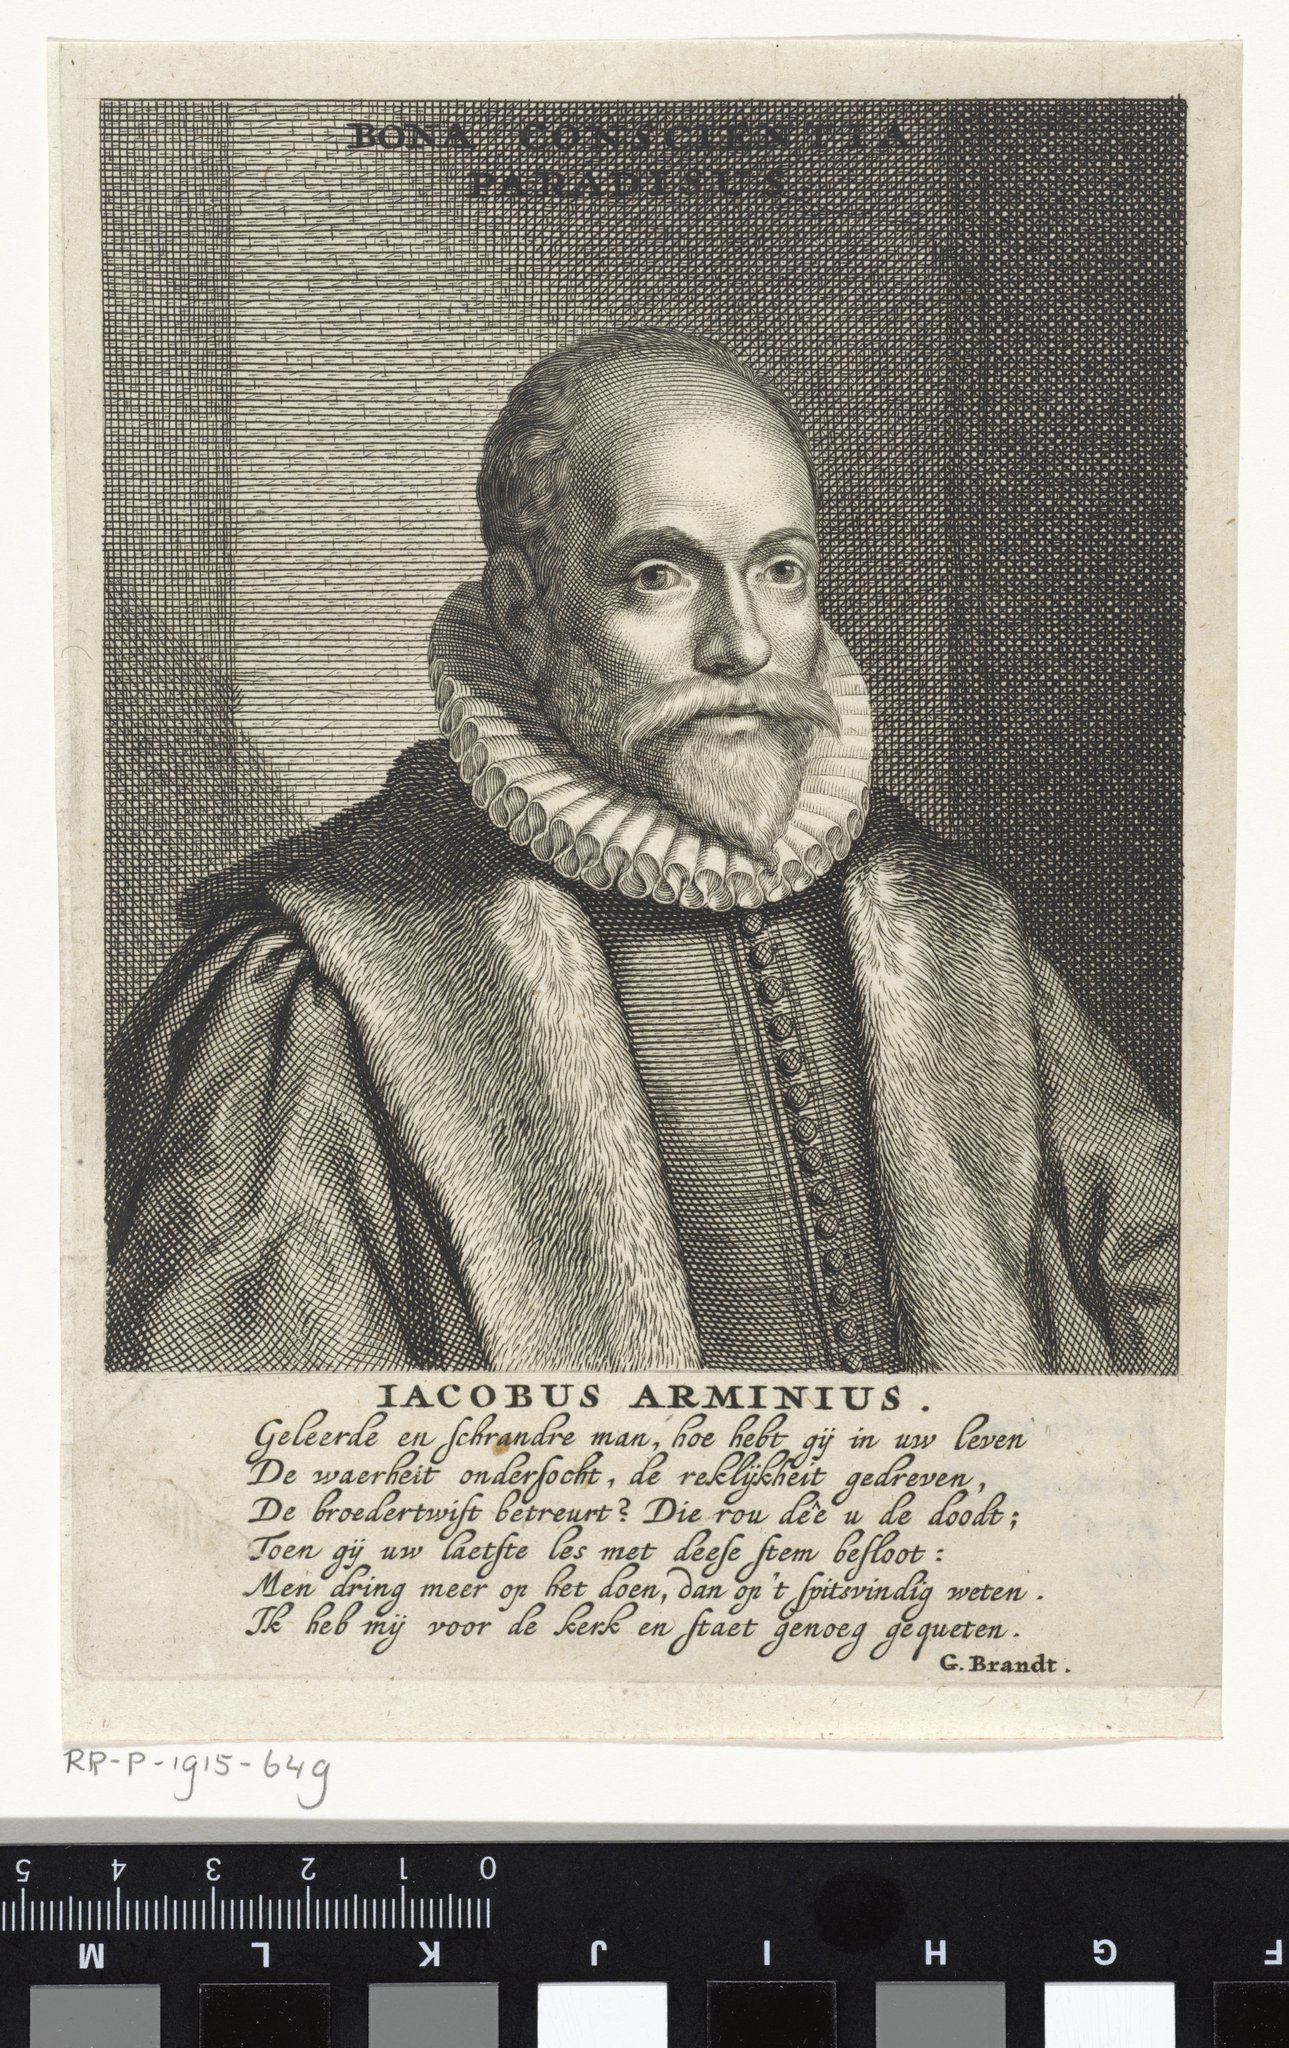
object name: print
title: Portret van Jacobus Arminius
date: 1696-1704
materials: paper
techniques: engraving, etching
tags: leiden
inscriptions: collector's mark: Lugt 2228, inscription: ‘gebooren Oudewater 1560-1609’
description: Prent gebruikt voor: Brandt, Geeraert. Historie der Reformatie (...). 4 dln. Amsterdam: Jan Rieuwertsz., Hendrik en Dirk Boom, 1671-1704, dl. 2, p. 86.